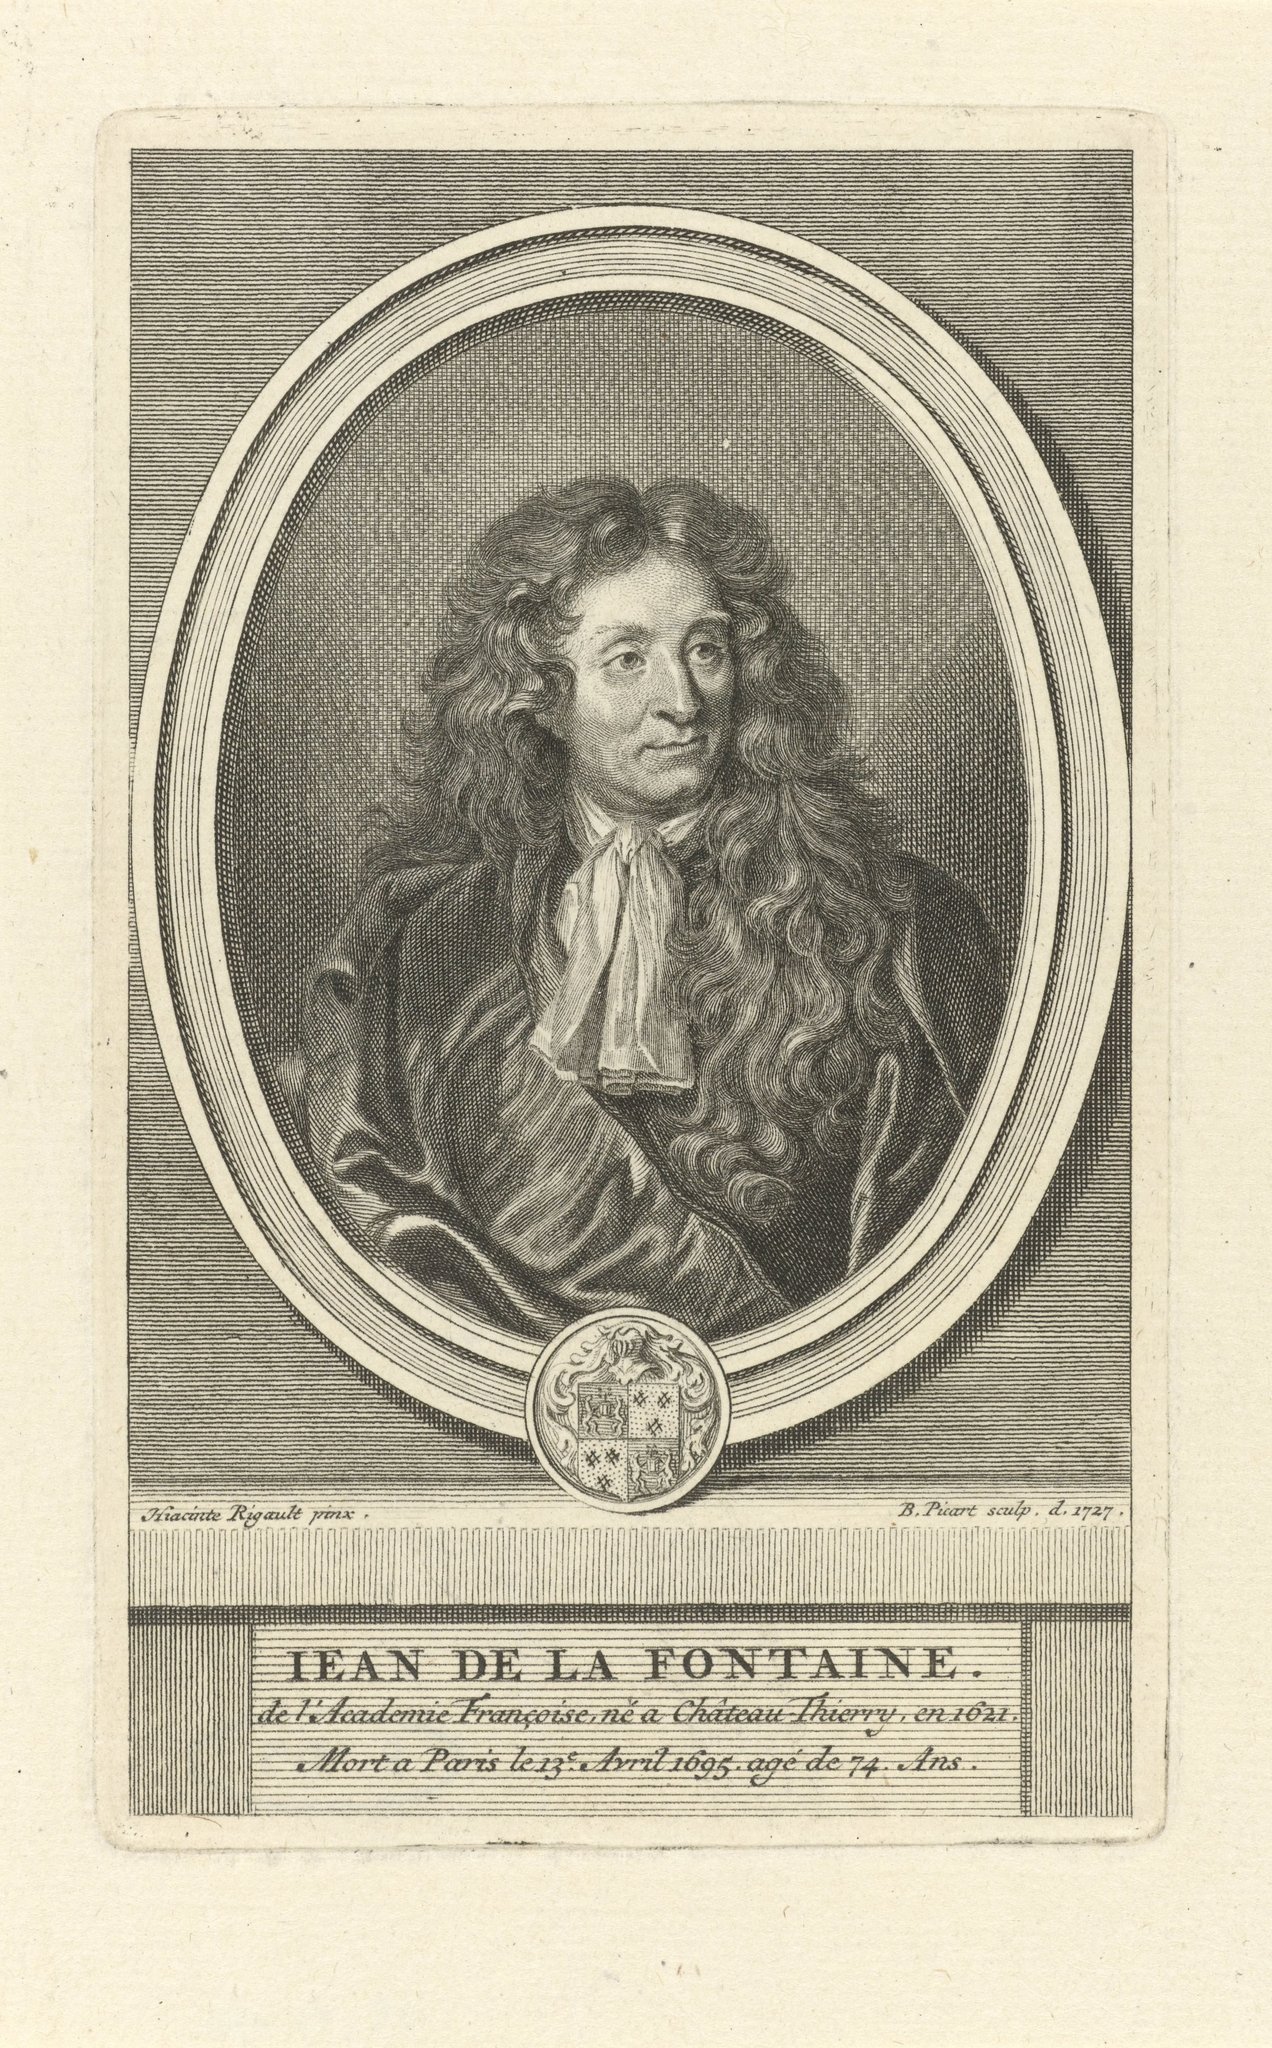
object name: print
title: Portret van Jean de La Fontaine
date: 1727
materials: paper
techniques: engraving, etching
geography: amsterdam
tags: paris, jean de la fontaine, portrait of a writer, armorial bearing, heraldry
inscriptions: collector's mark: Lugt 2228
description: Portret van de Franse schrijver Jean de La Fontaine. Op de omlijsting zijn wapenschild. In het kader een onderschrift in het Frans.